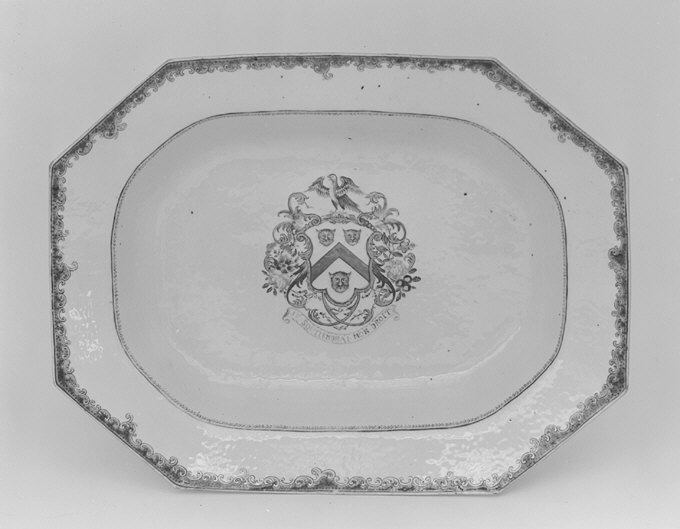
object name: platter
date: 1740-1750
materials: hard paste porcelain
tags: birds,coat of arms